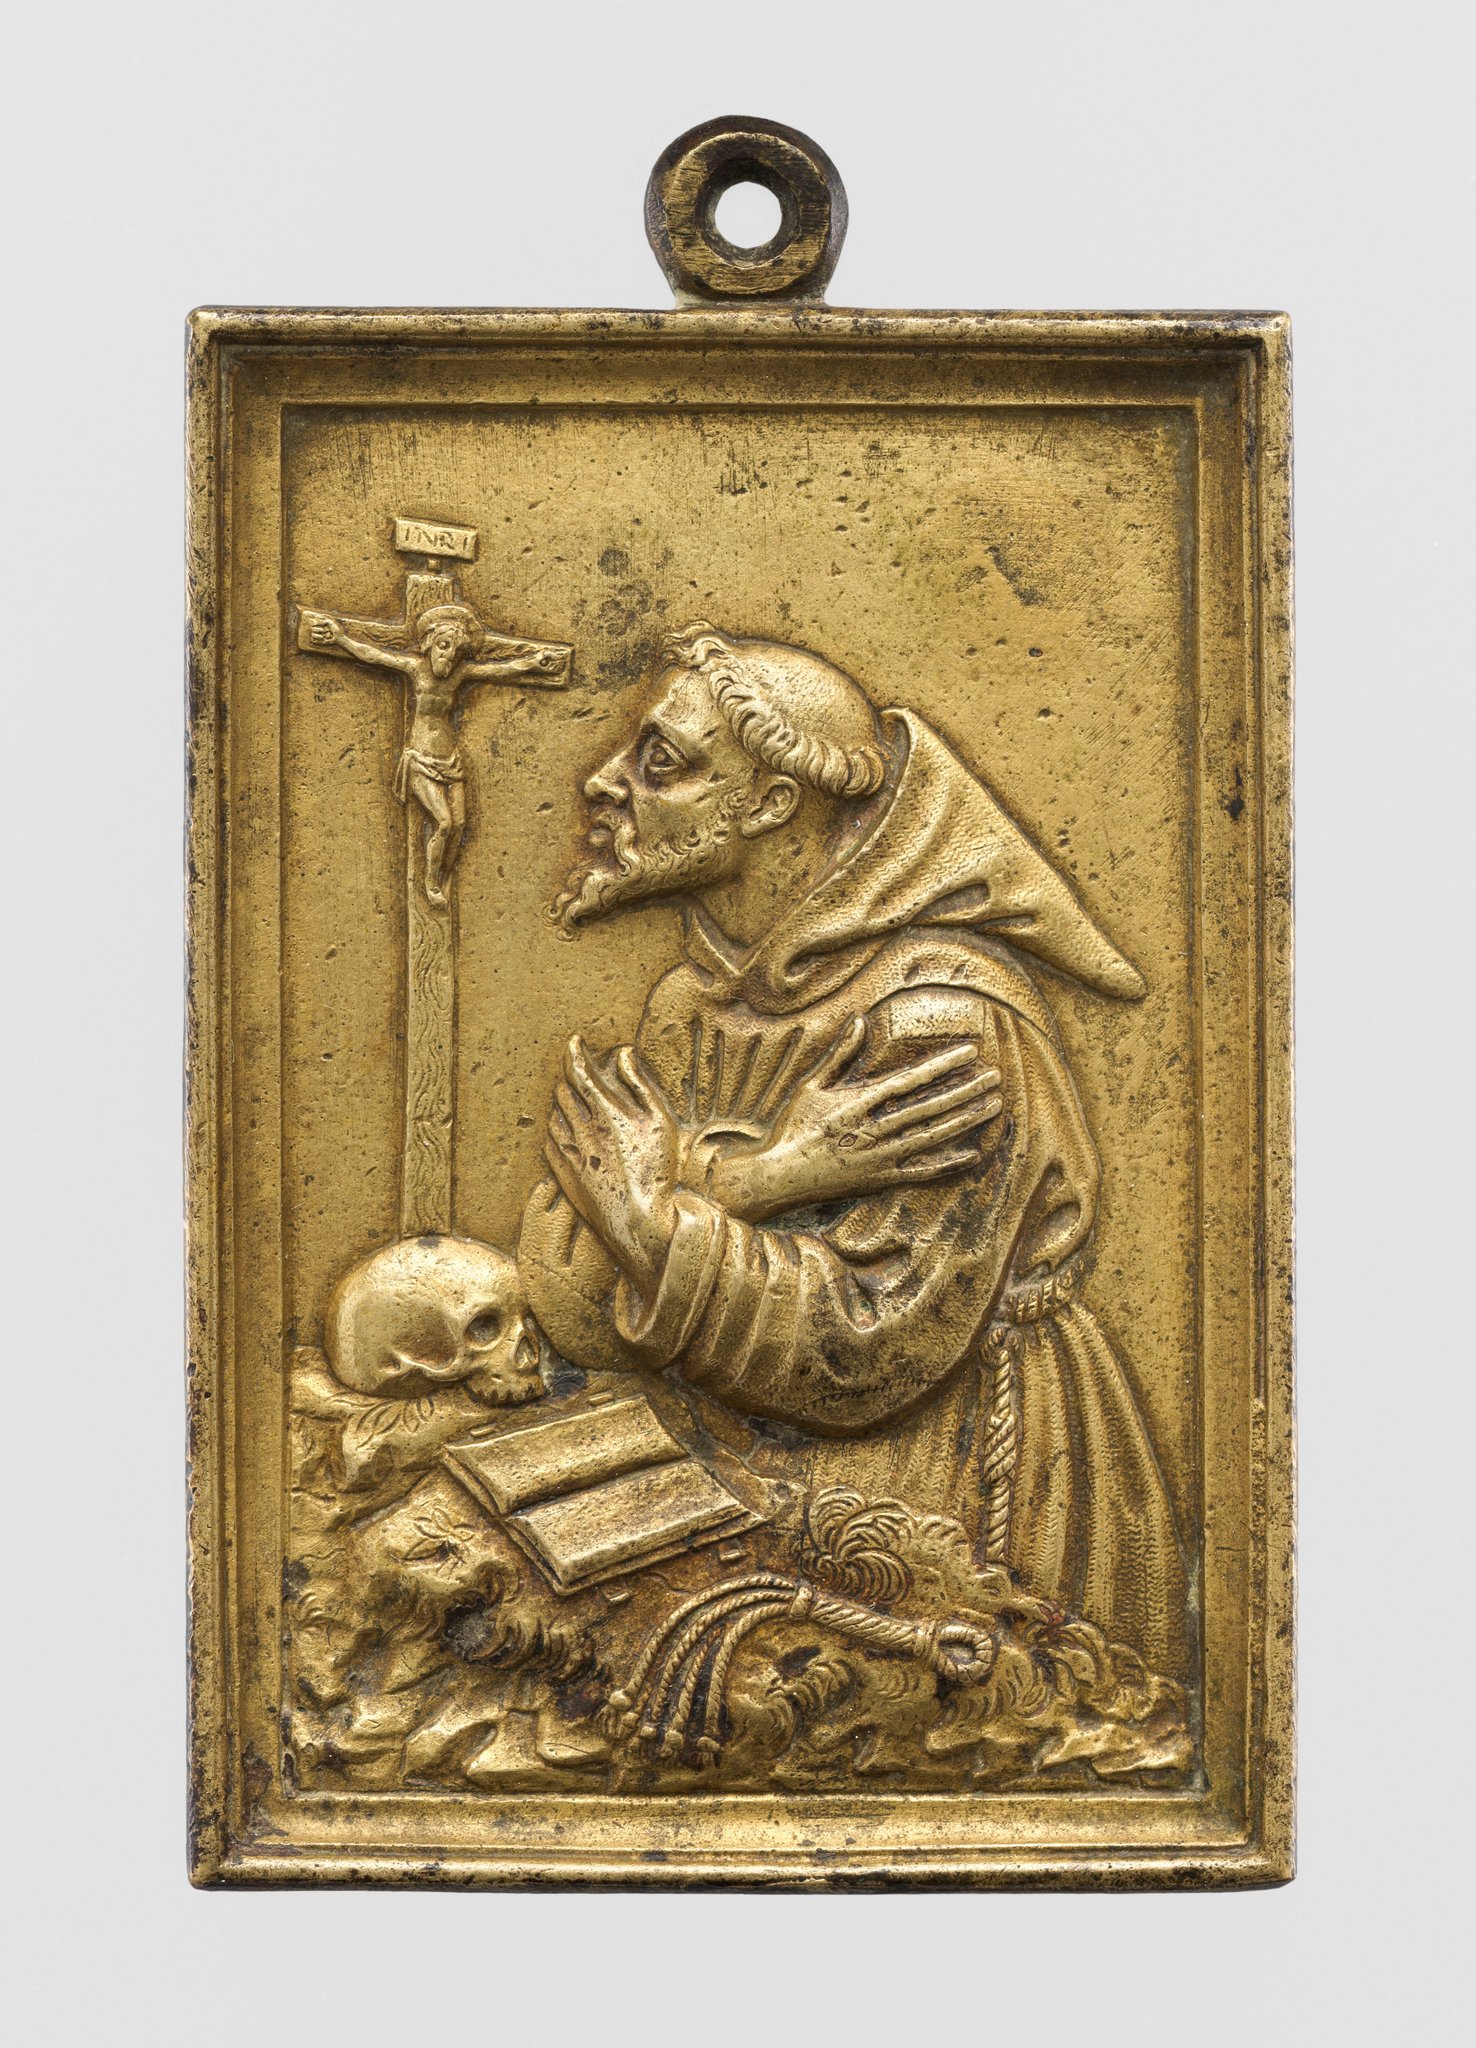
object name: plaquette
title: Saint Francis of Assisi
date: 1601-1633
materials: gilt bronze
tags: skulls,christ,saint francis,cross